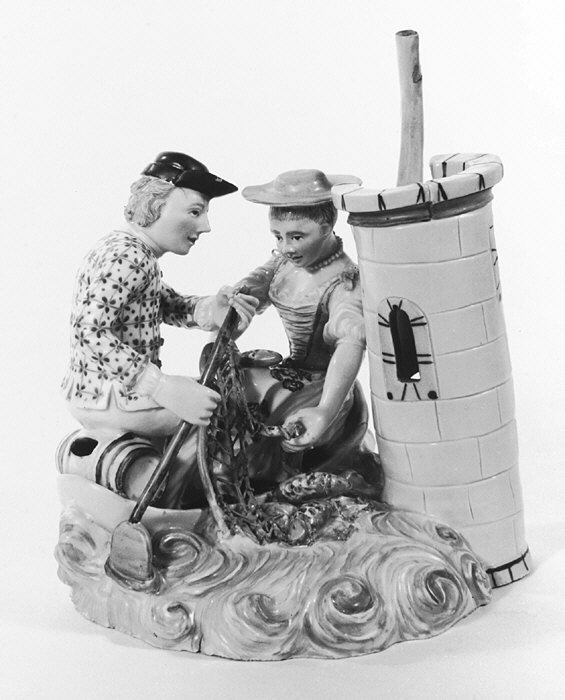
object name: group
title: Youth and girl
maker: ansbach pottery and porcelain manufactory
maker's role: manufactory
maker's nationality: german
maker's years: 1758-1860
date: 1760-1780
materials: hard paste porcelain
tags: boys,girls